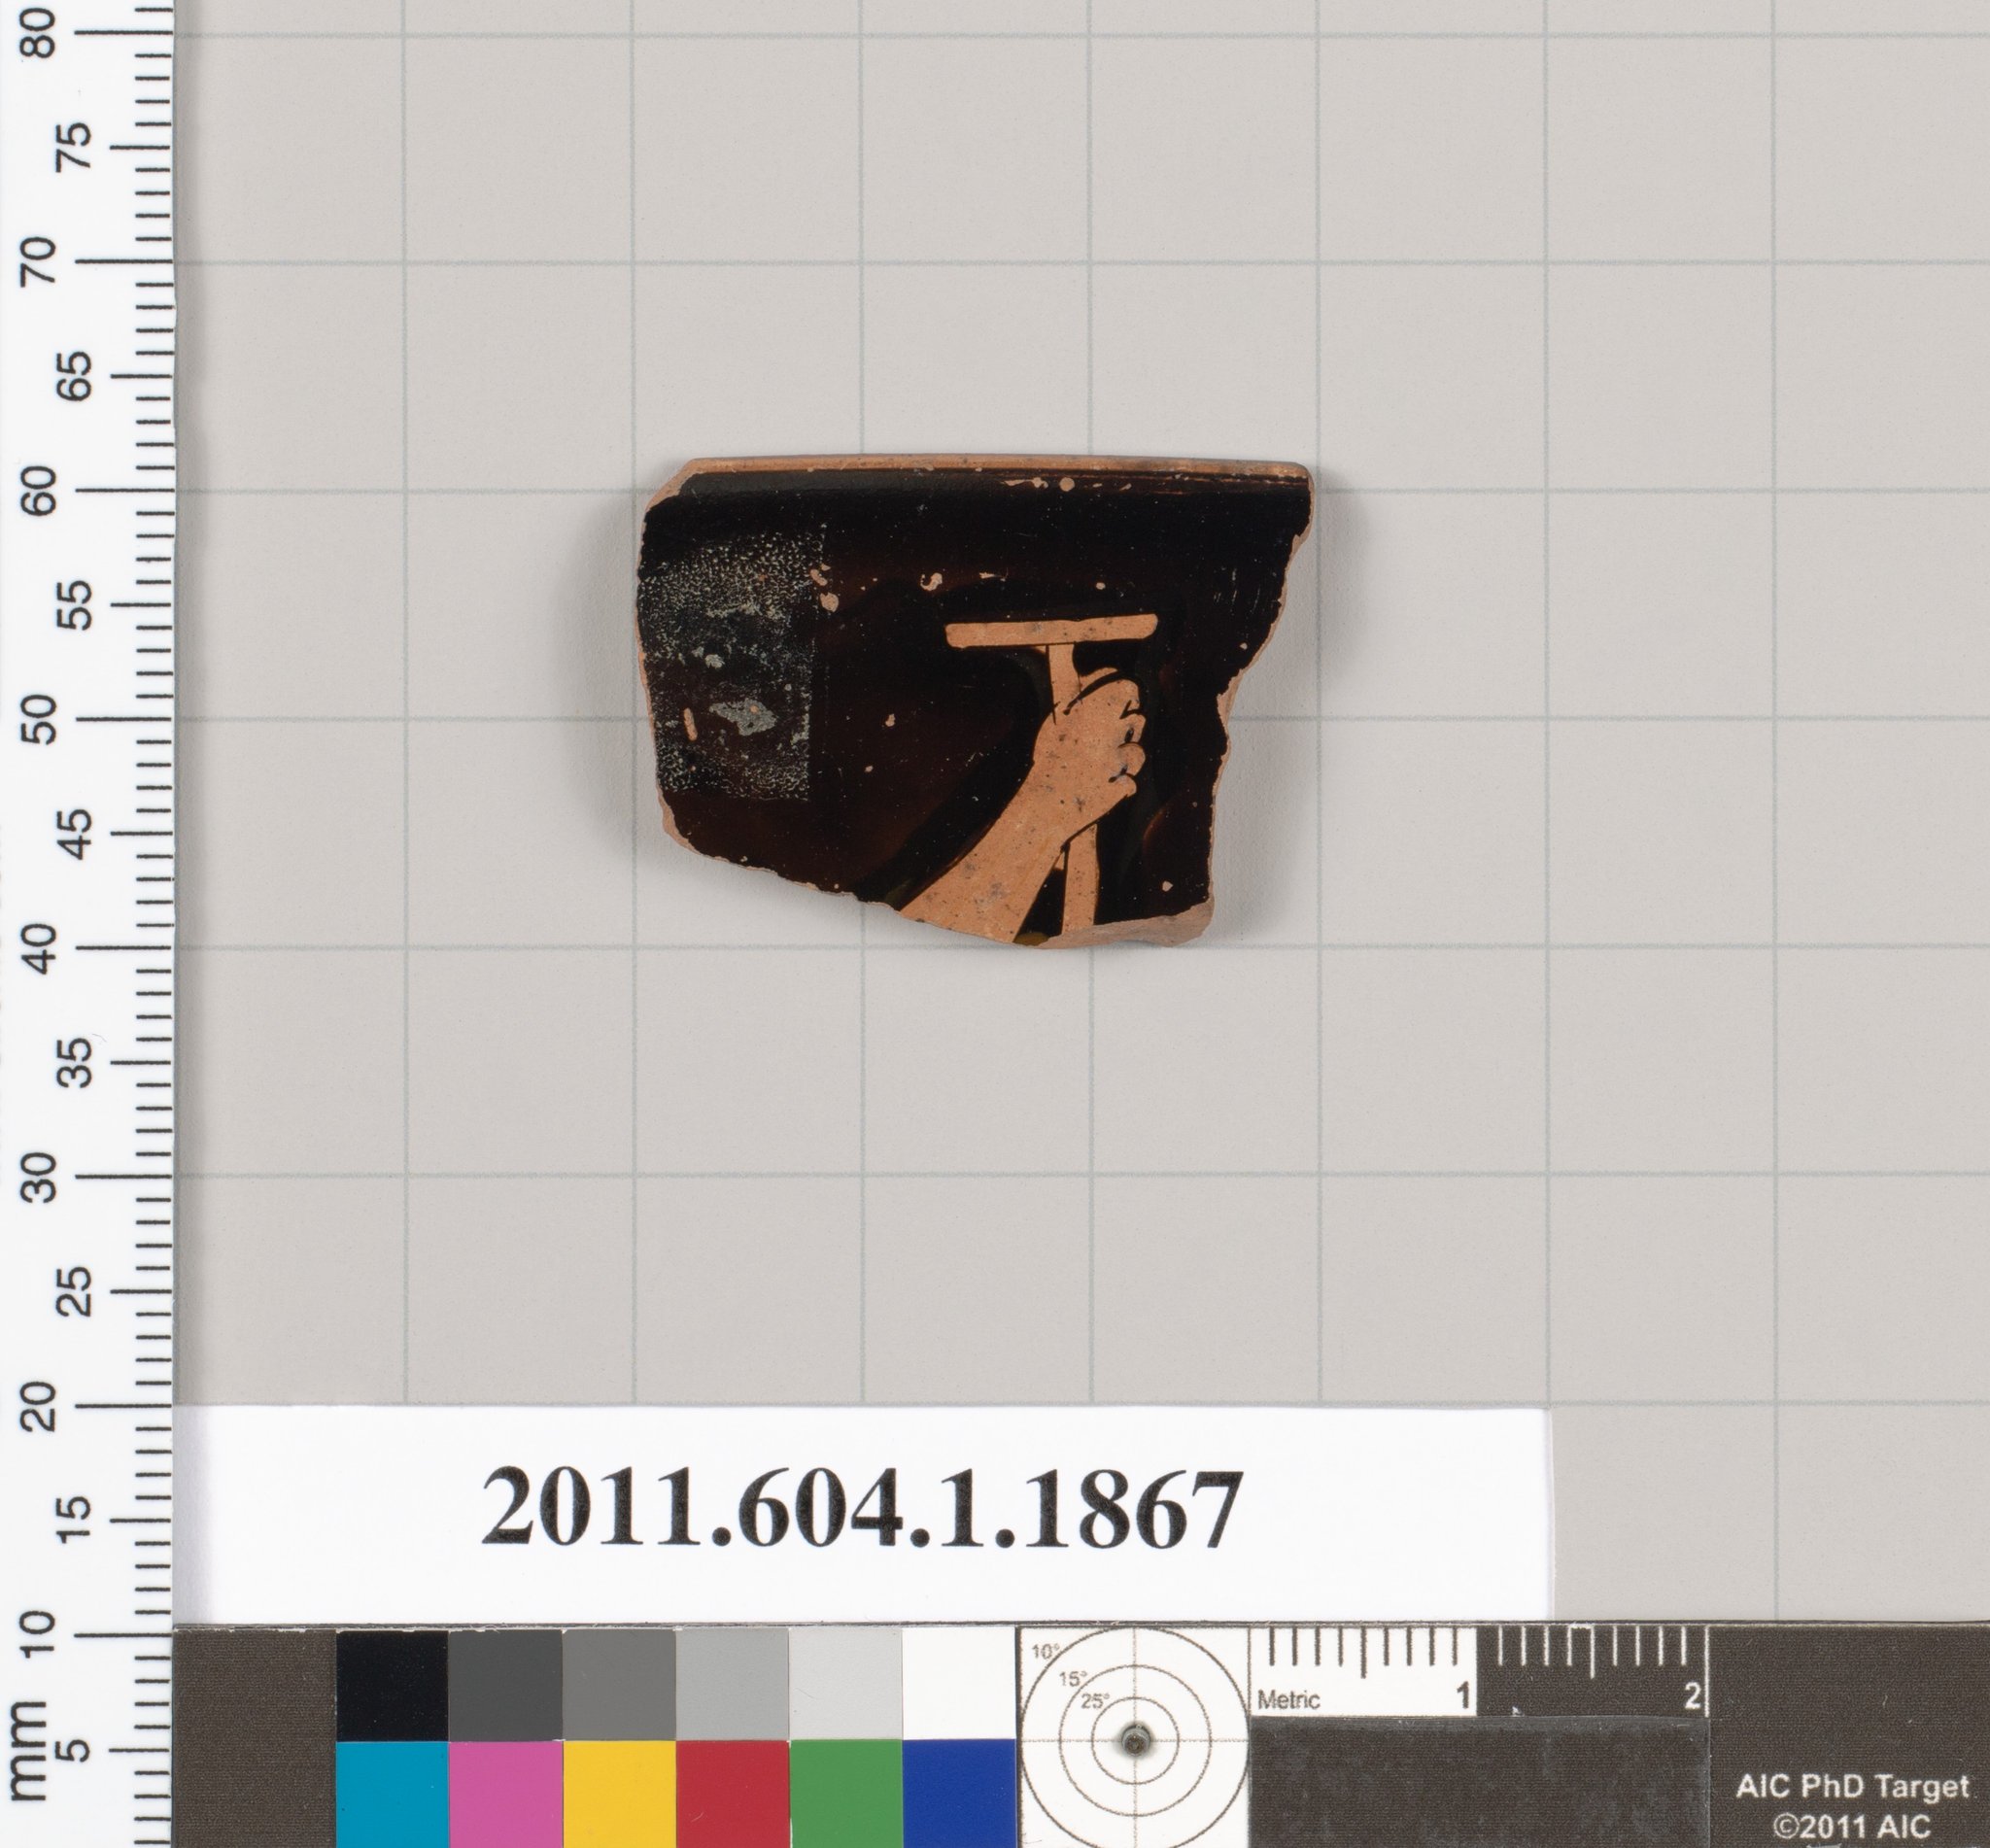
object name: kylix fragment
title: Terracotta rim fragment of a kylix (drinking cup)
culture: greek, attic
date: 475-451 BCE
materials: terracotta